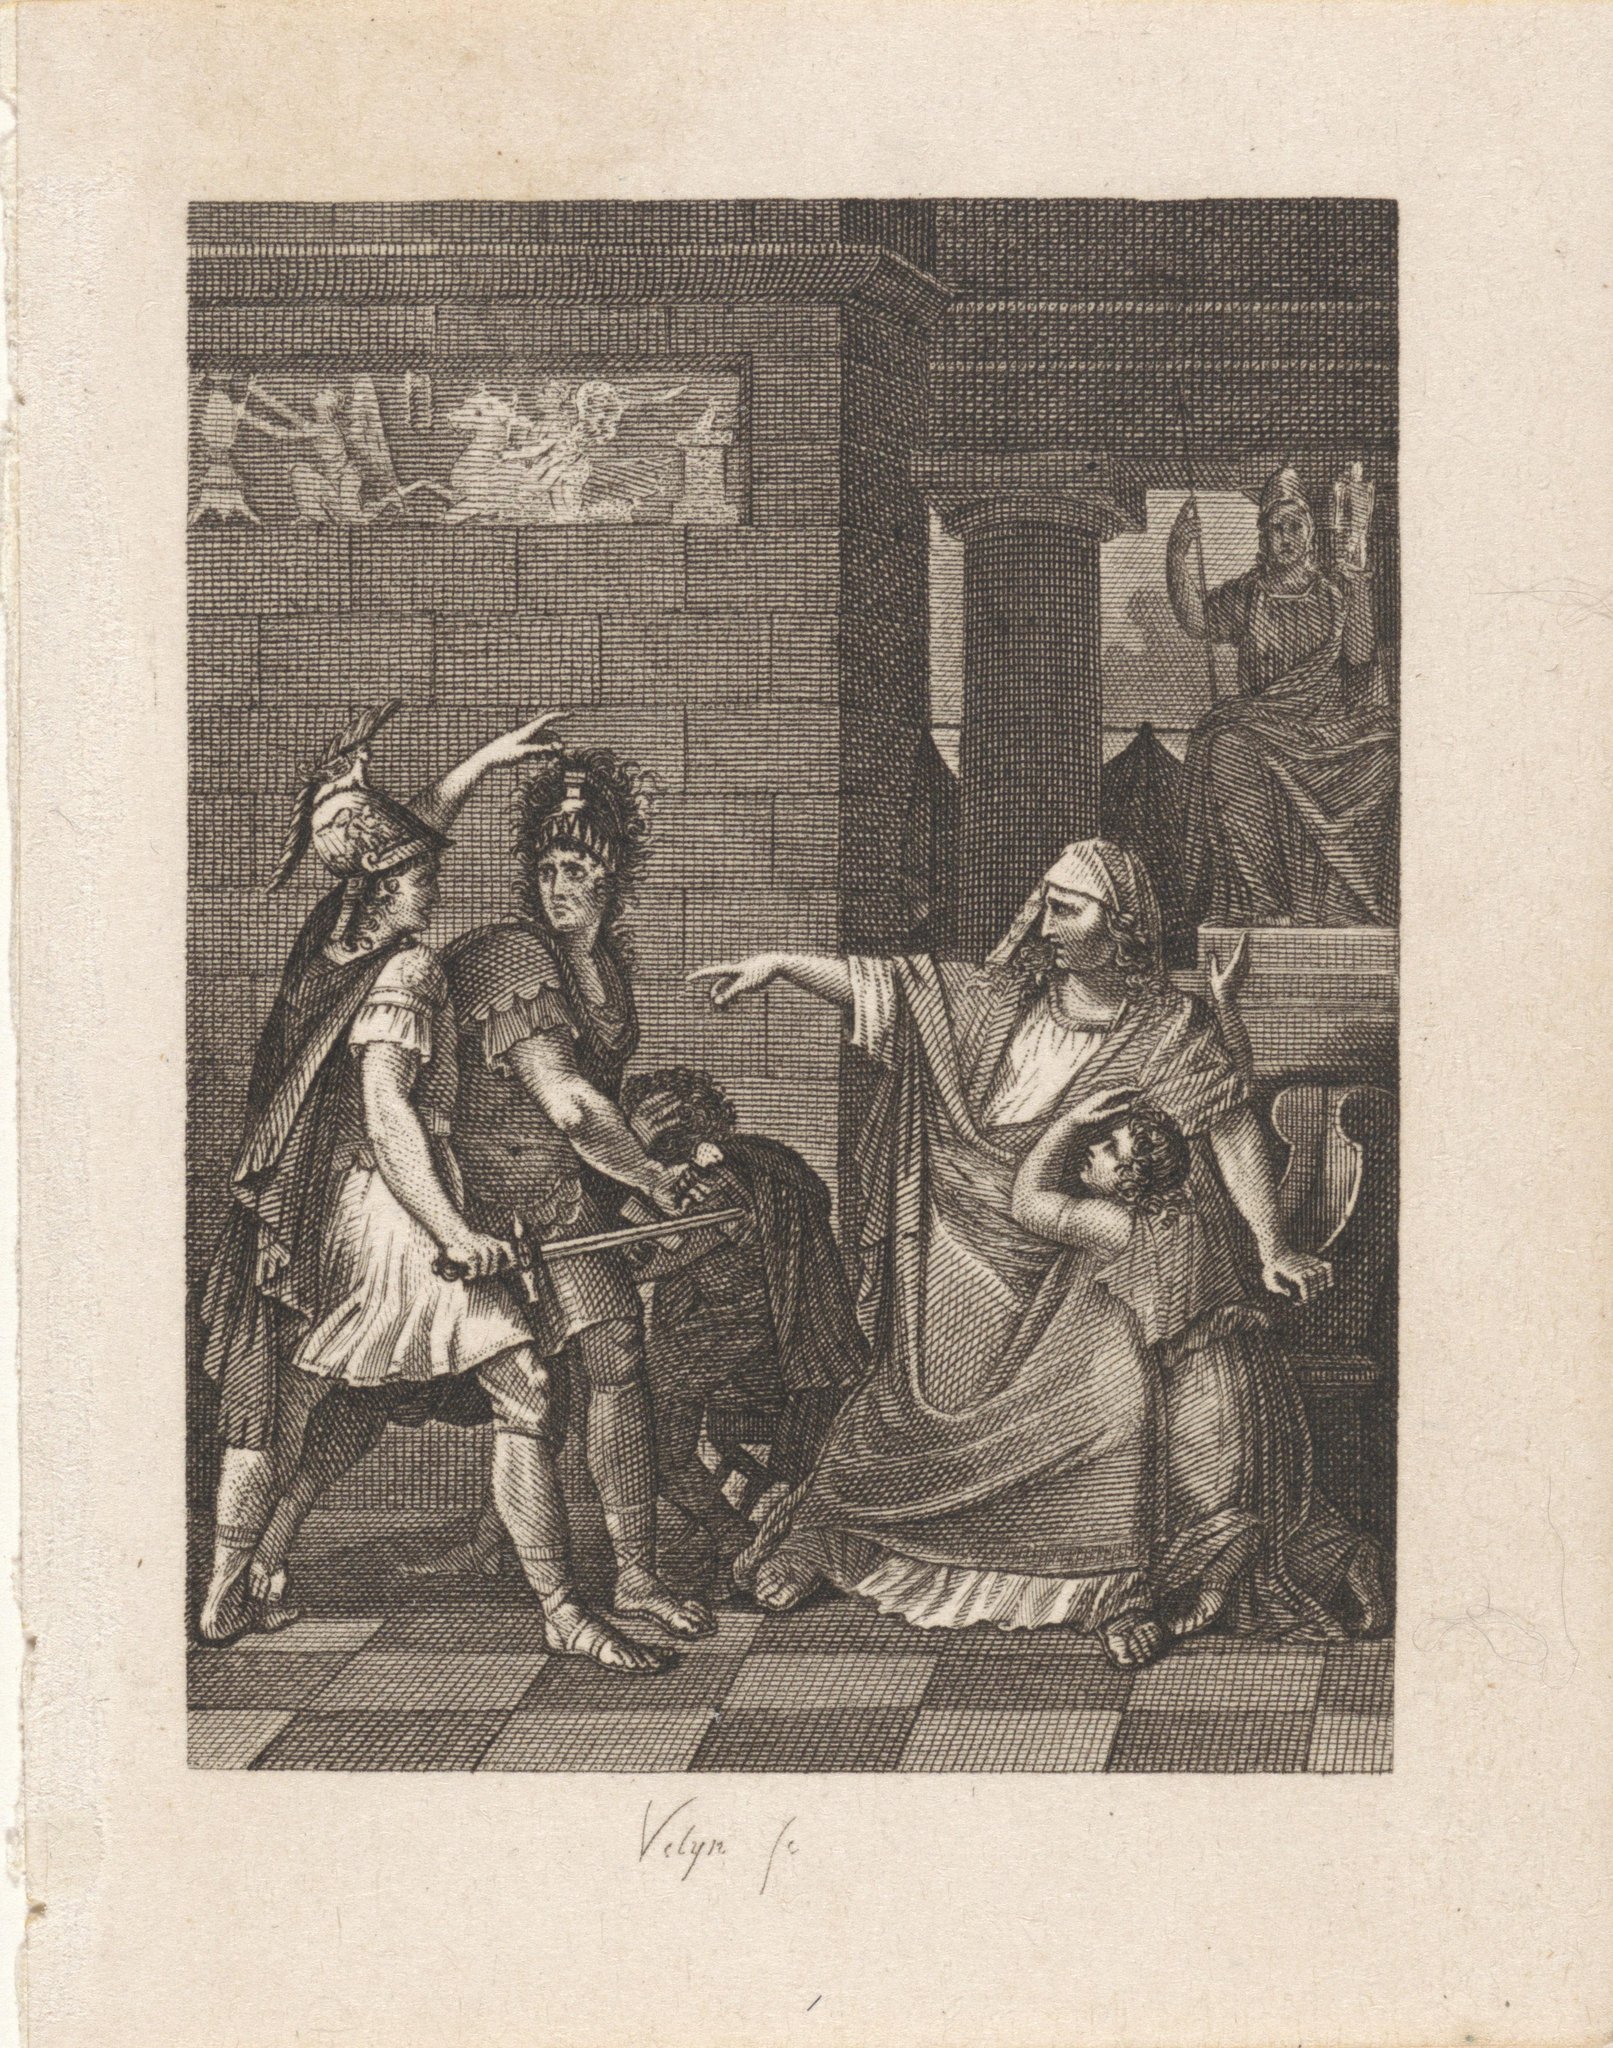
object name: print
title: Twee mannen met zwaarden voor een vrouw met een kind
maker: philippus velijn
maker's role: print maker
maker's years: 1787-1836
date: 1822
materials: paper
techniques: engraving, etching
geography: netherlands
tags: hacking and thrusting weapons: sword, index finger forwards, pointing, indicating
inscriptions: collector's mark: Lugt 2228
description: Een vouw met naast haar een geknield kind wijst op twee krijgers die met getrokken zwaarden voor haar staan. Een van de mannen wijst naar een zittende figuur met een lans op een verhoging achter de vrouw.